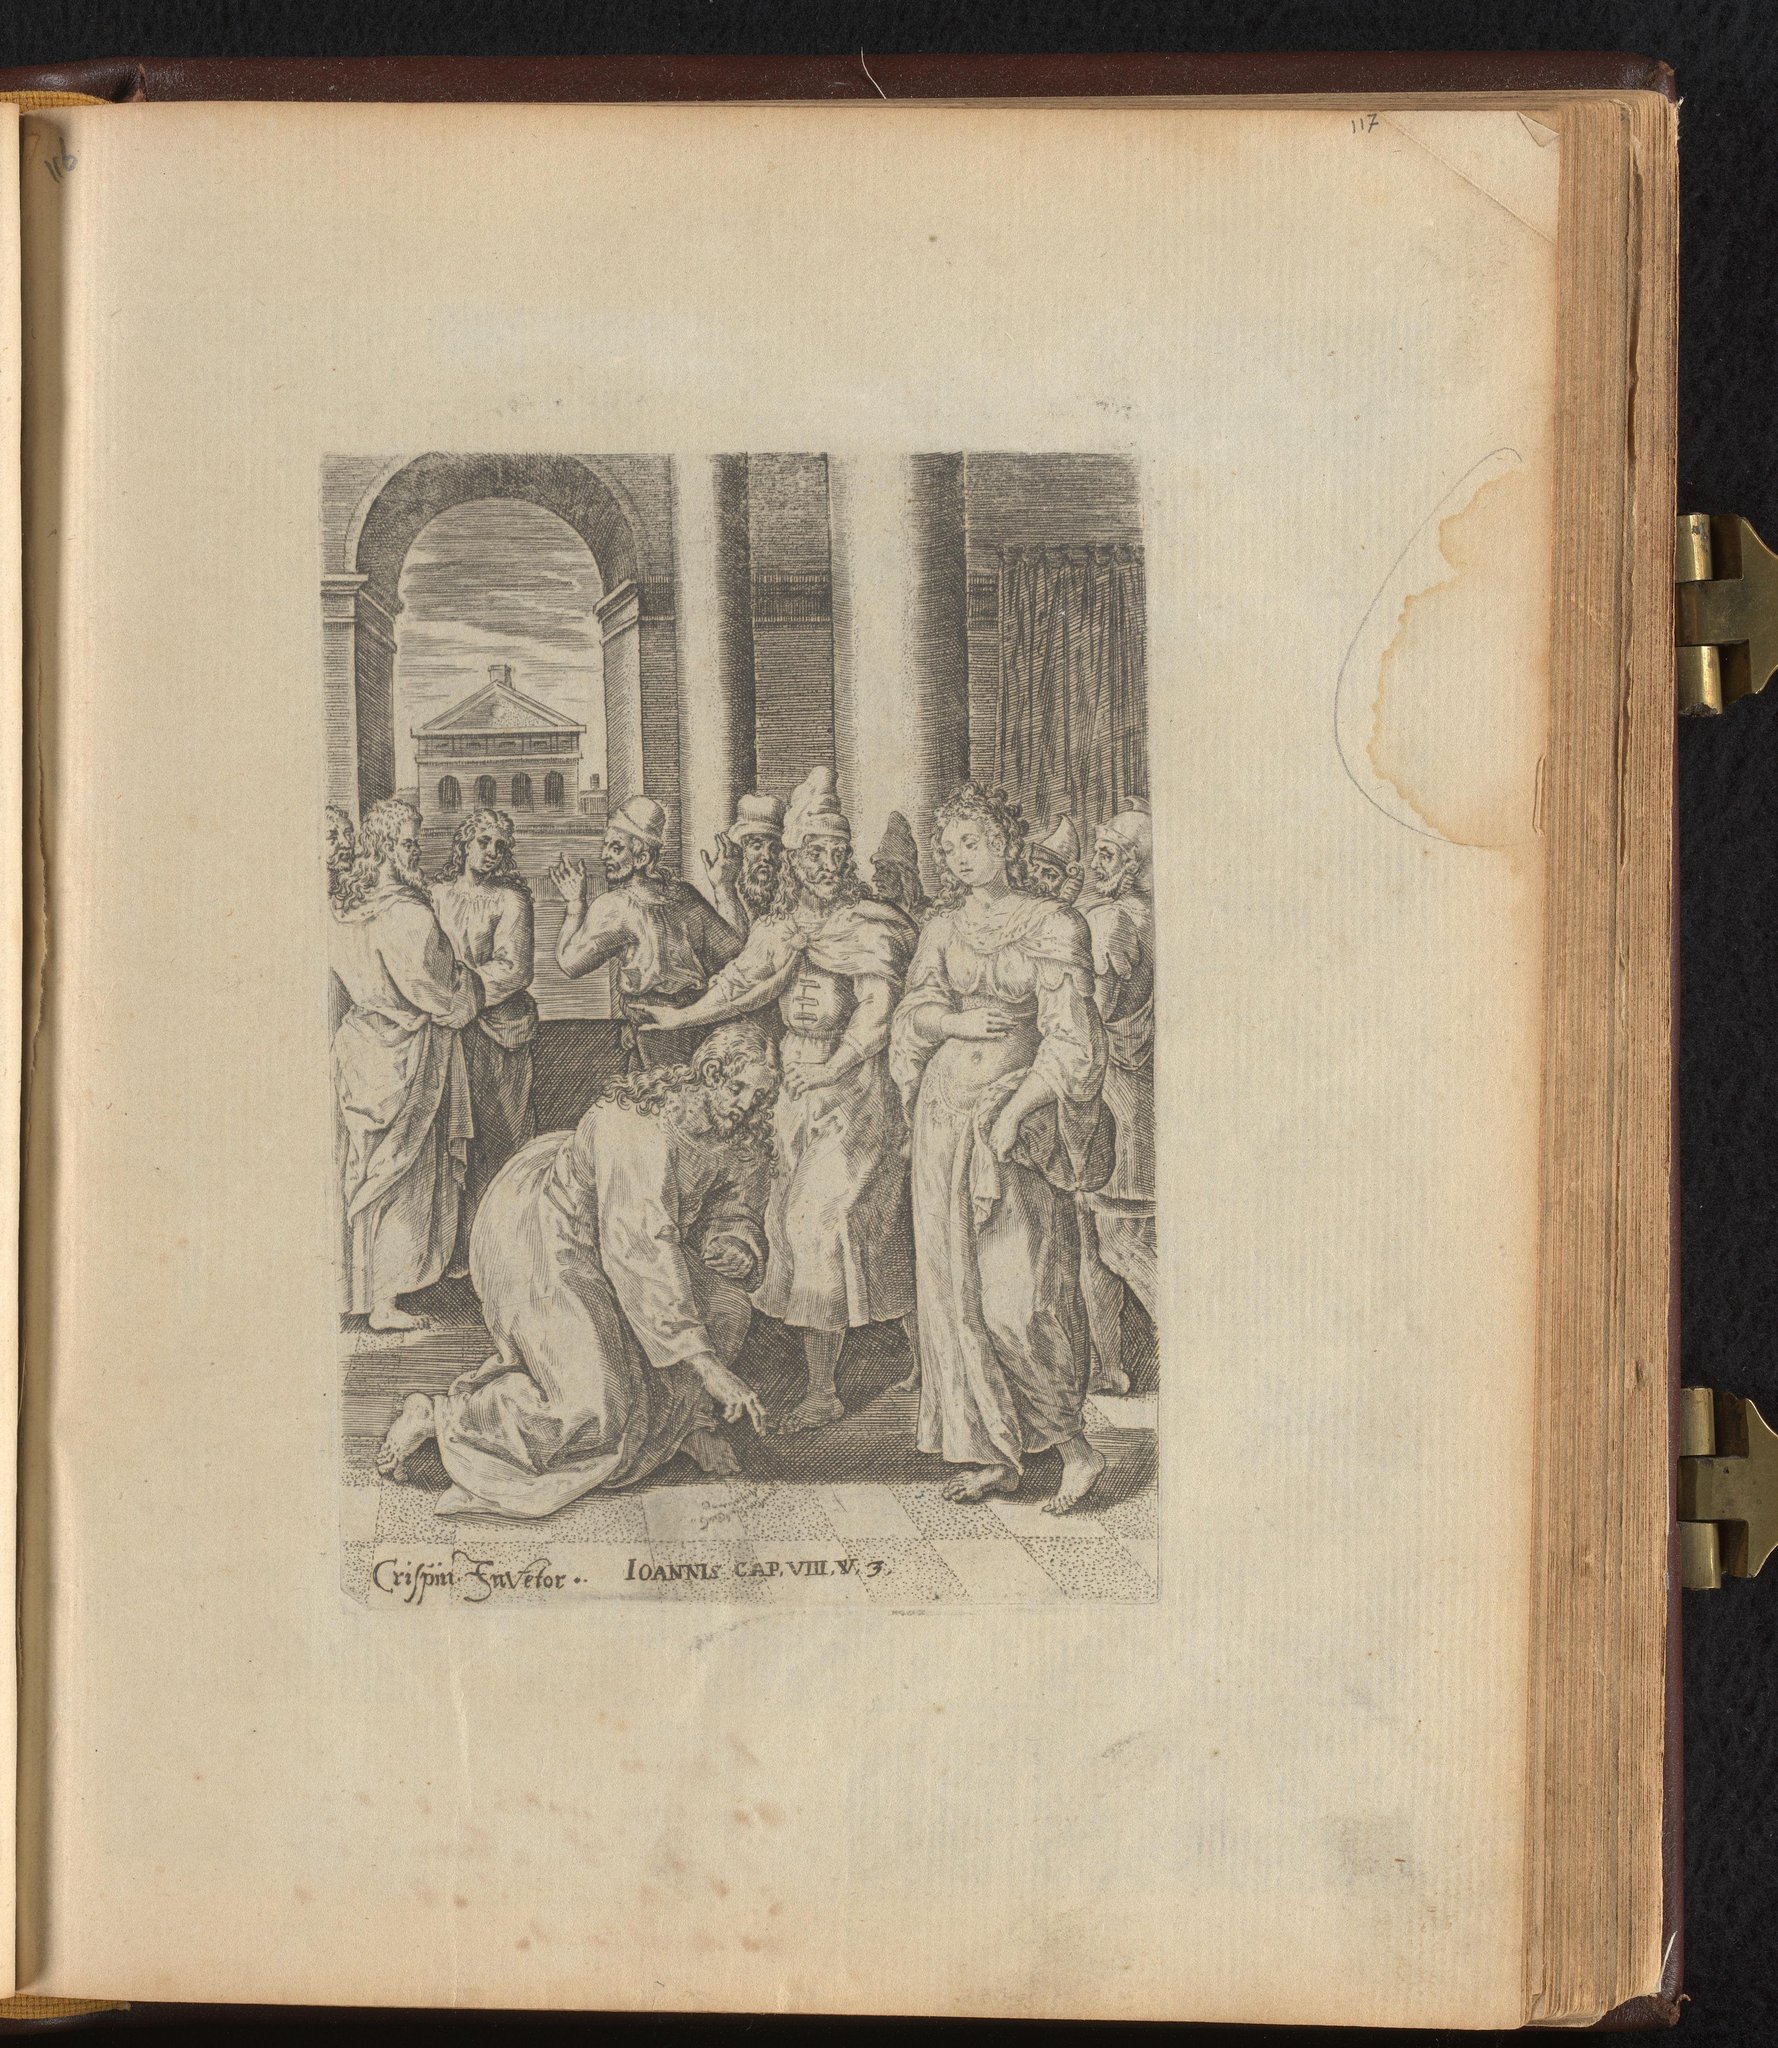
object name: album leaf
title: Christus en de overspelige vrouw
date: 1583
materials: paper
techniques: engraving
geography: southern netherlands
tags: christ points to or writes on the ground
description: Eerdere staat van prent gebruikt als boekillustratie in: Biblia Sacra. Antwerpen: Christoffel Plantijn, 1583.